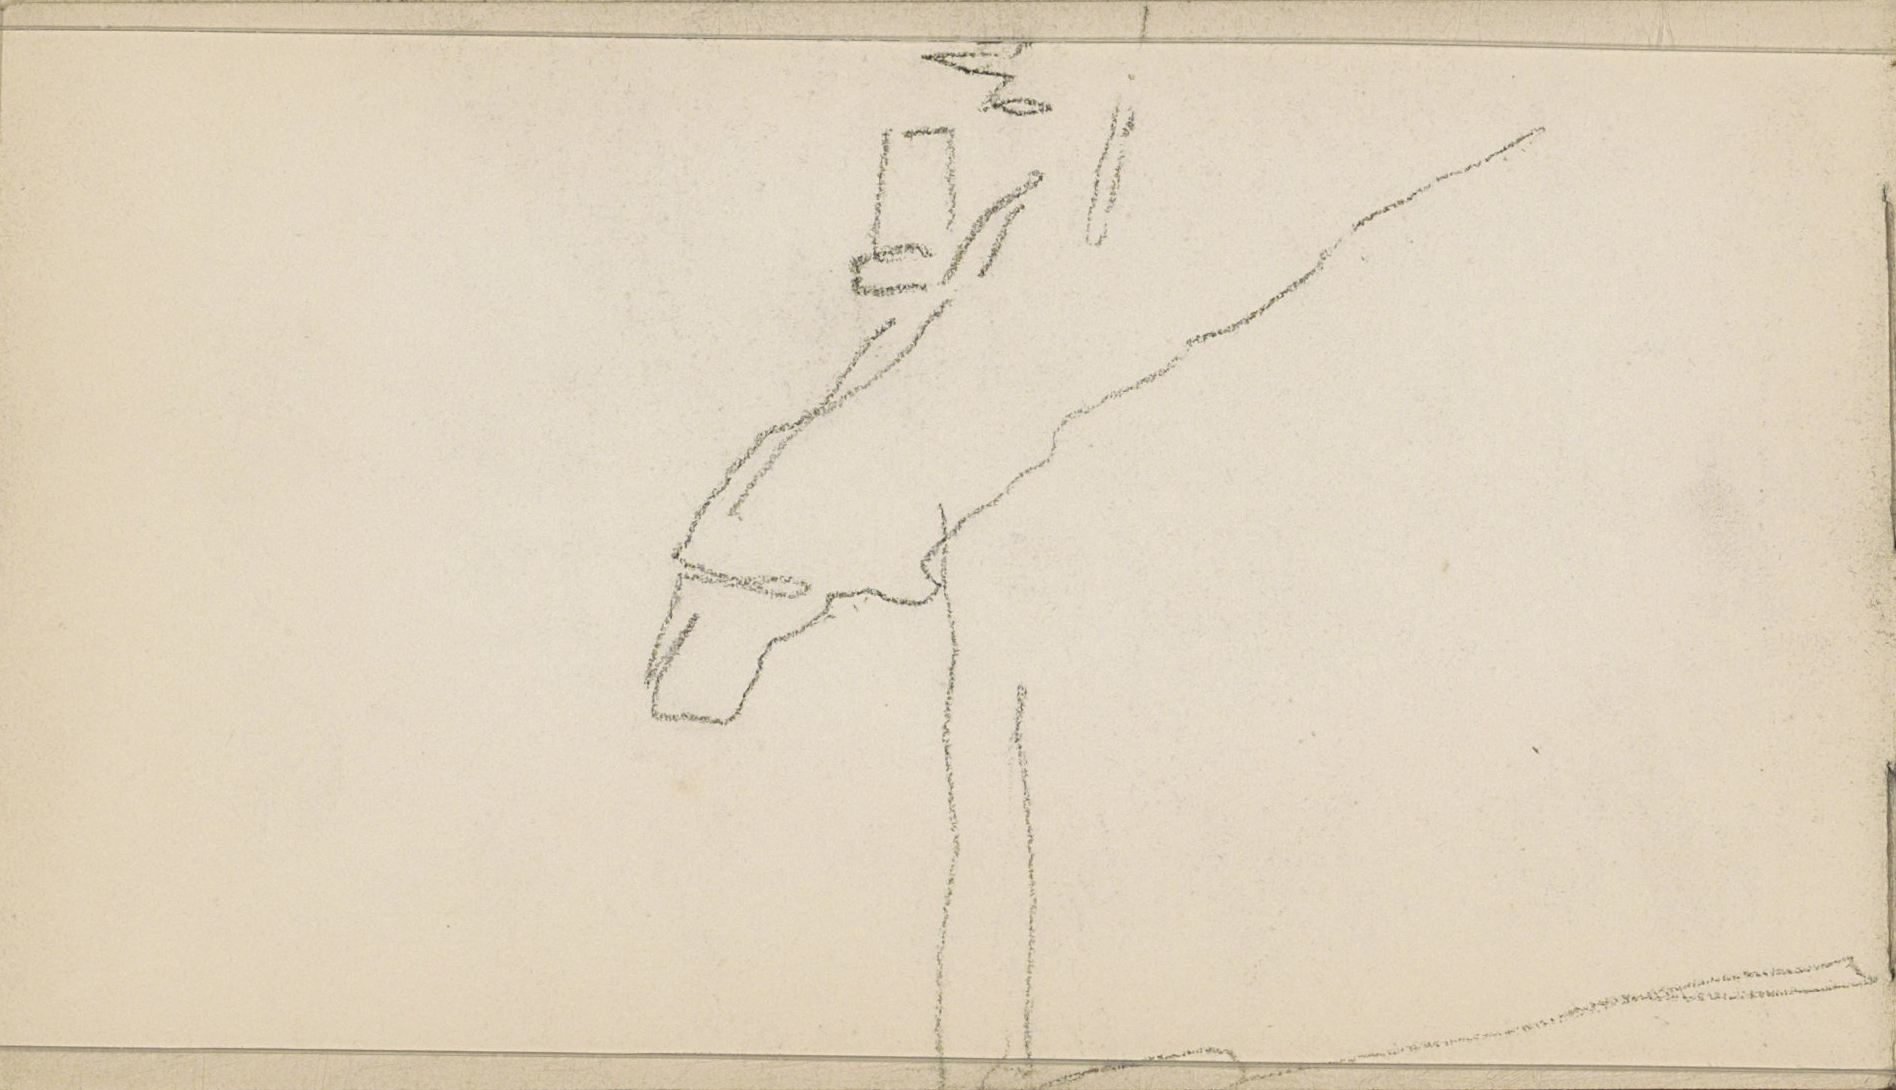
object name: sketchbook leaf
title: Studie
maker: anton mauve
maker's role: draughtsman, painter, print maker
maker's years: 1838-1888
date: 1876-1879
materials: chalk, paper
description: Blad 21 verso uit een schetsboek met 33 bladen.